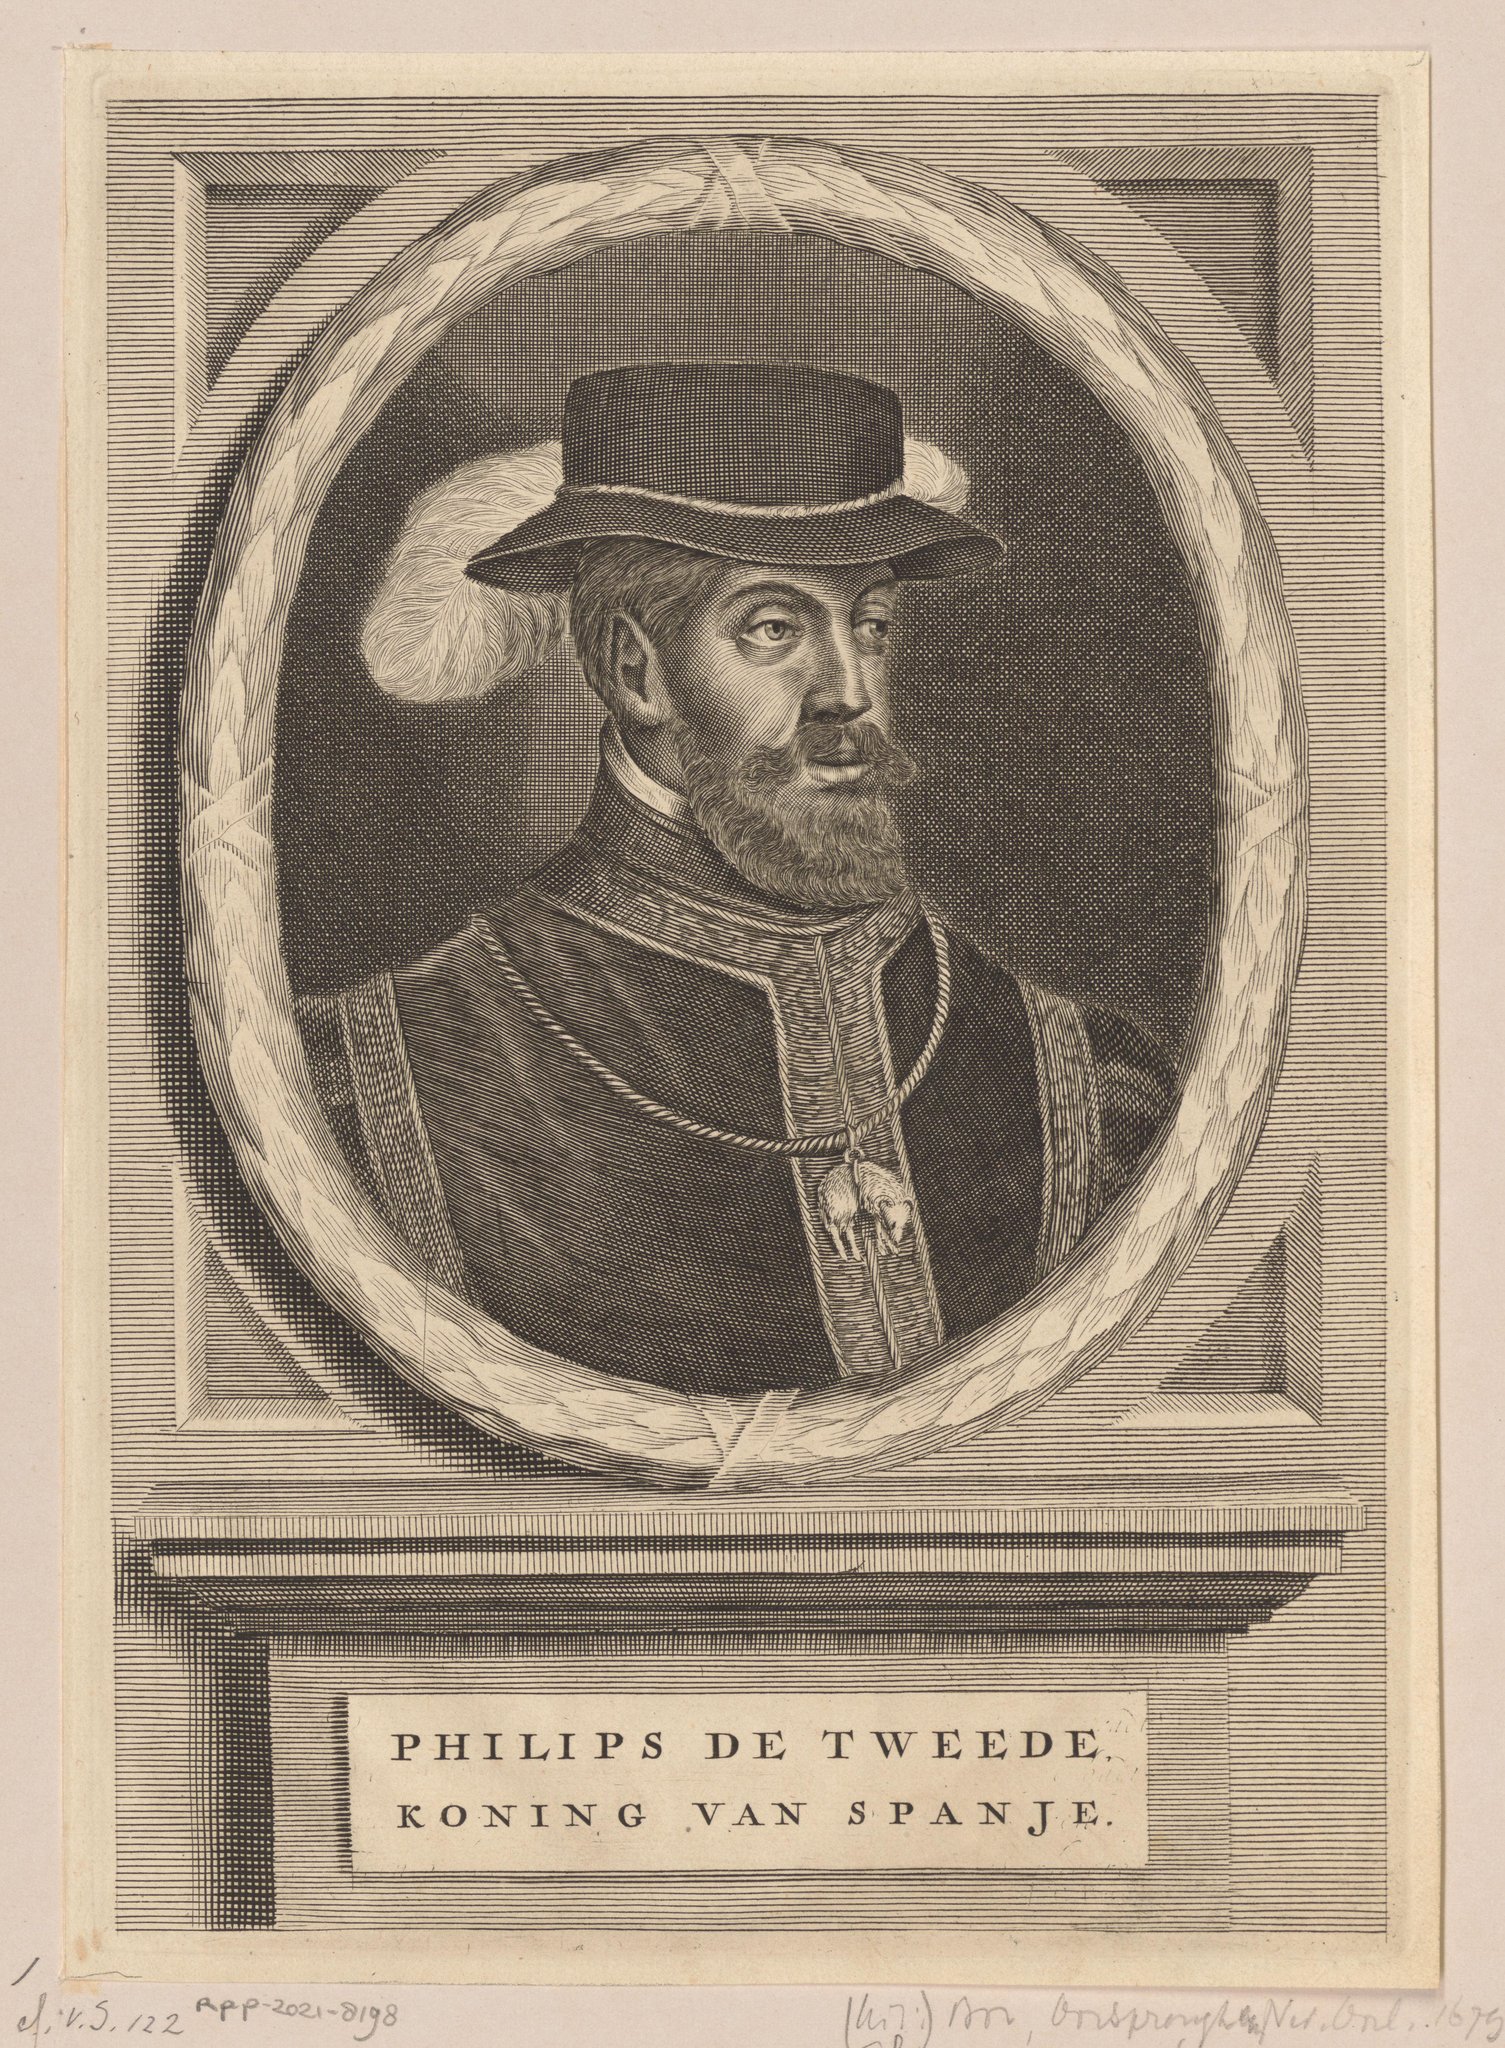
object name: print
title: Portret van Filips II, koning van Spanje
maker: Anonymous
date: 1679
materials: paper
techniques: engraving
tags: philip ii of spain, head-gear, adult man, historical persons, knighthood order of the golden fleece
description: Prent waarschijnlijk uit: Bor, Pieter Christiaensz. Oorsprongk, begin, en vervolgh der Nederlandsche oorlogen, beroerten, en borgerlyke oneenigheden (...). Amsterdam: weduwe Joannes van Someren, Abraham Wolfgangh en Hendrick en Dirck Boom, 1679, dl. 1.